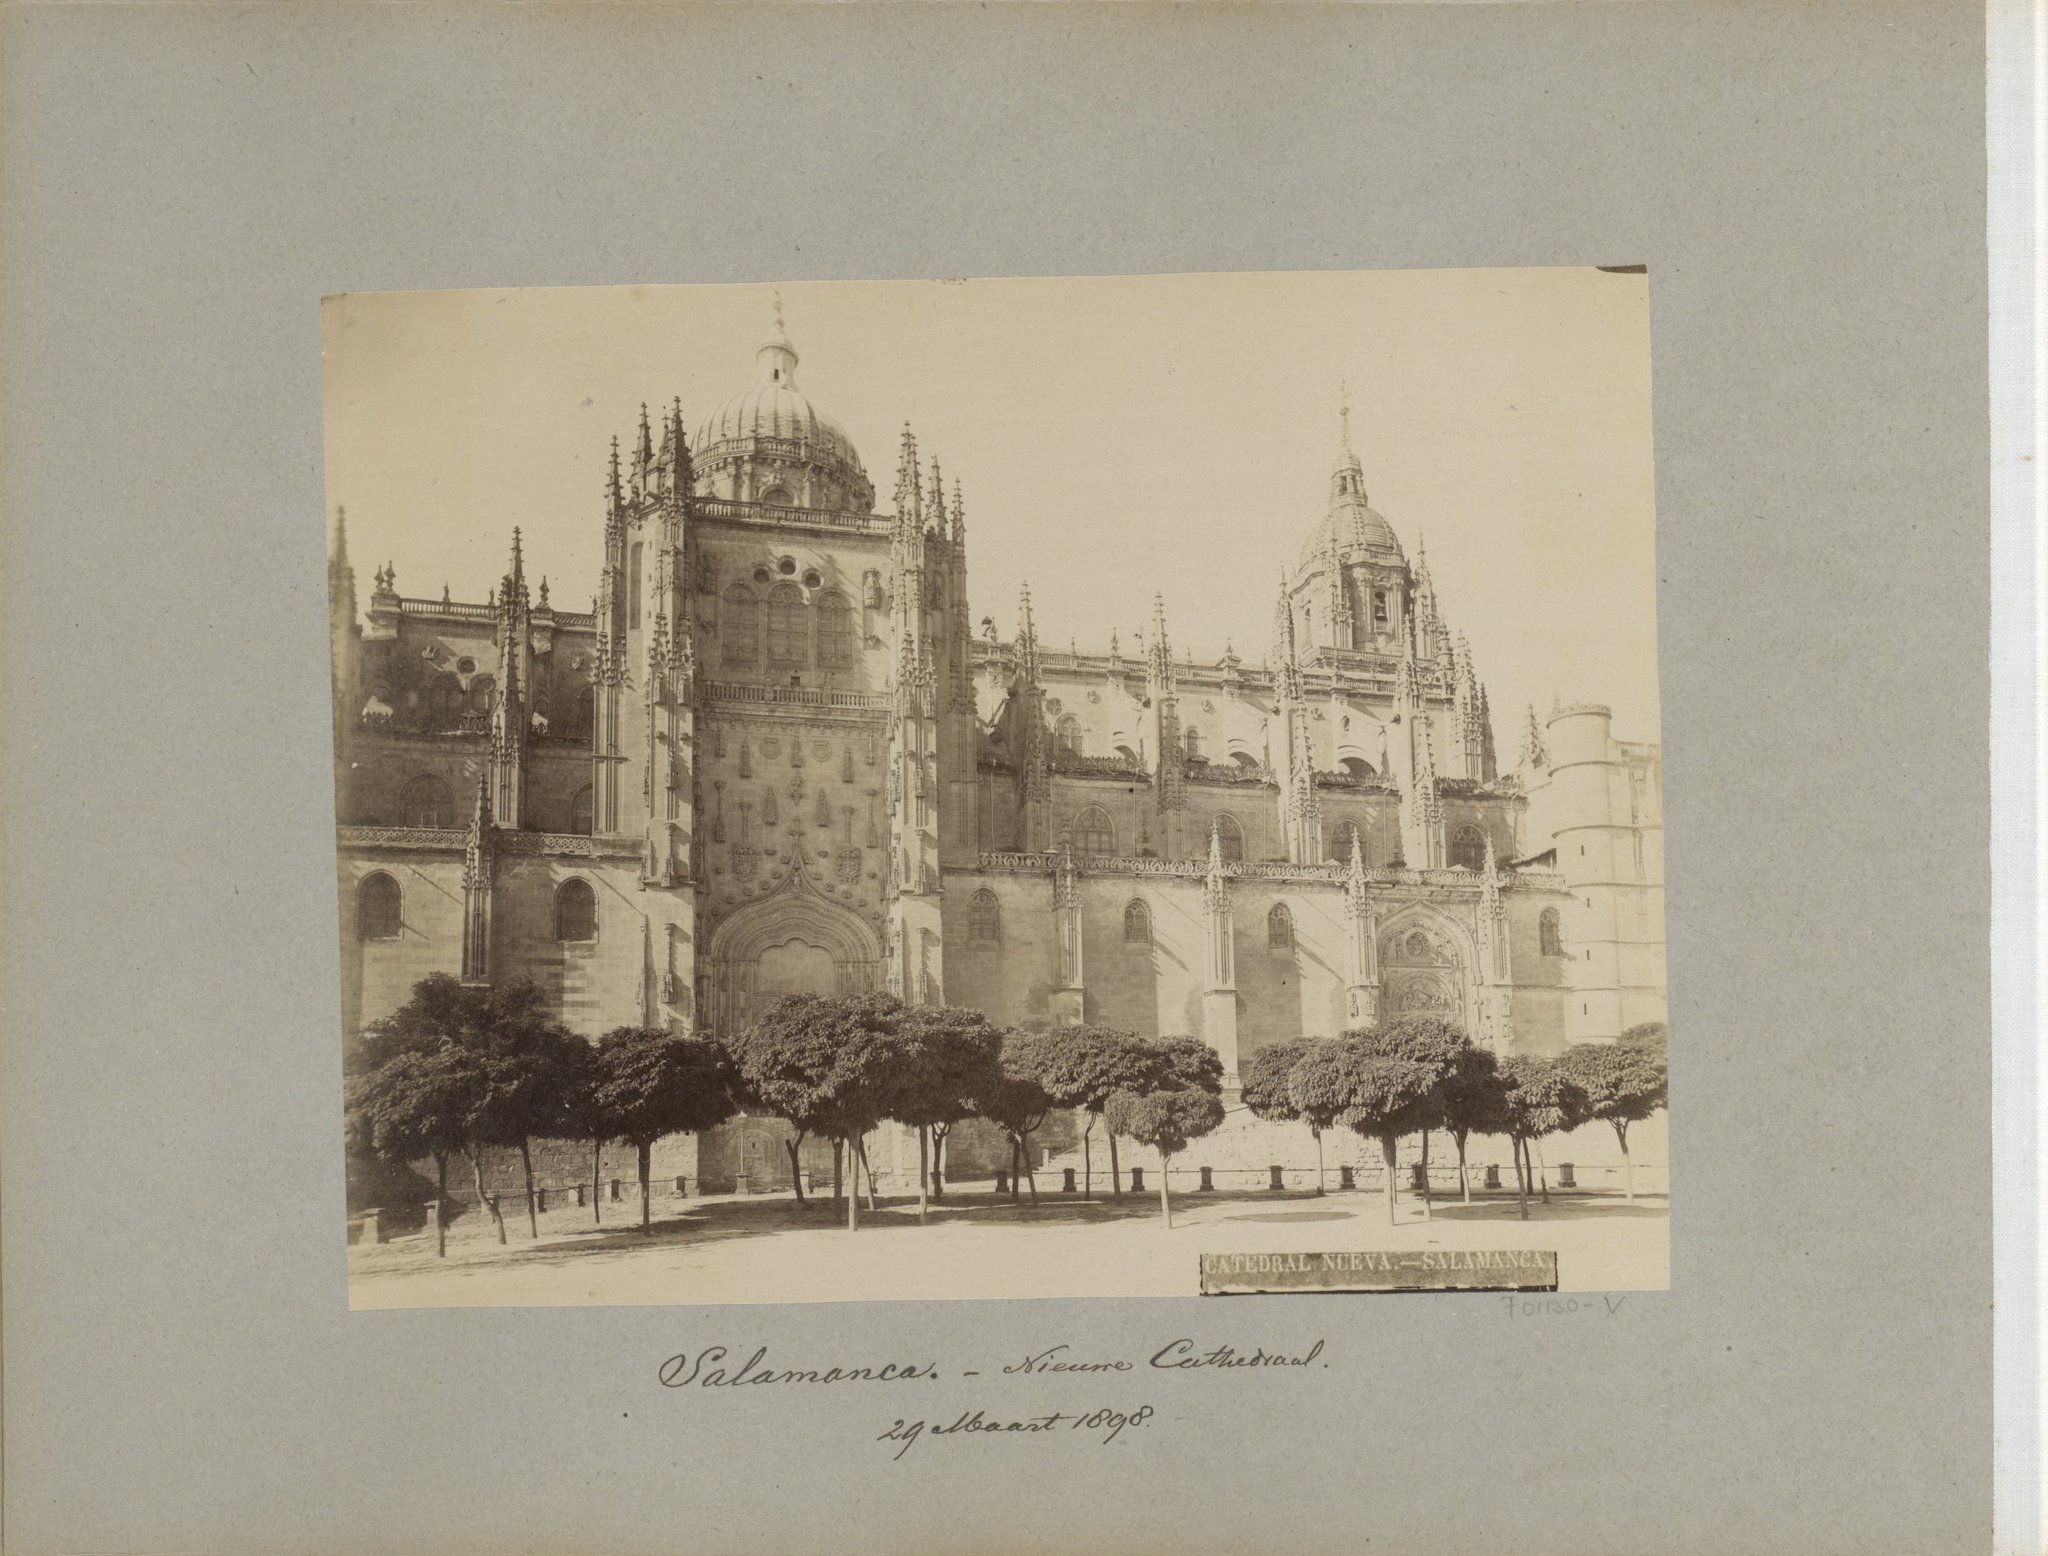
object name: album leaf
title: Cathedral Nueva. - Salamanca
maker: Anonymous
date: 1880-1898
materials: paper, photographic support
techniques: albumen print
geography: salamanca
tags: church (exterior)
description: Onderdeel van Reisalbum met foto's van bezienswaardigheden in Frankrijk, Spanje, Italië, Duitsland, Zwitserland en Oostenrijk.